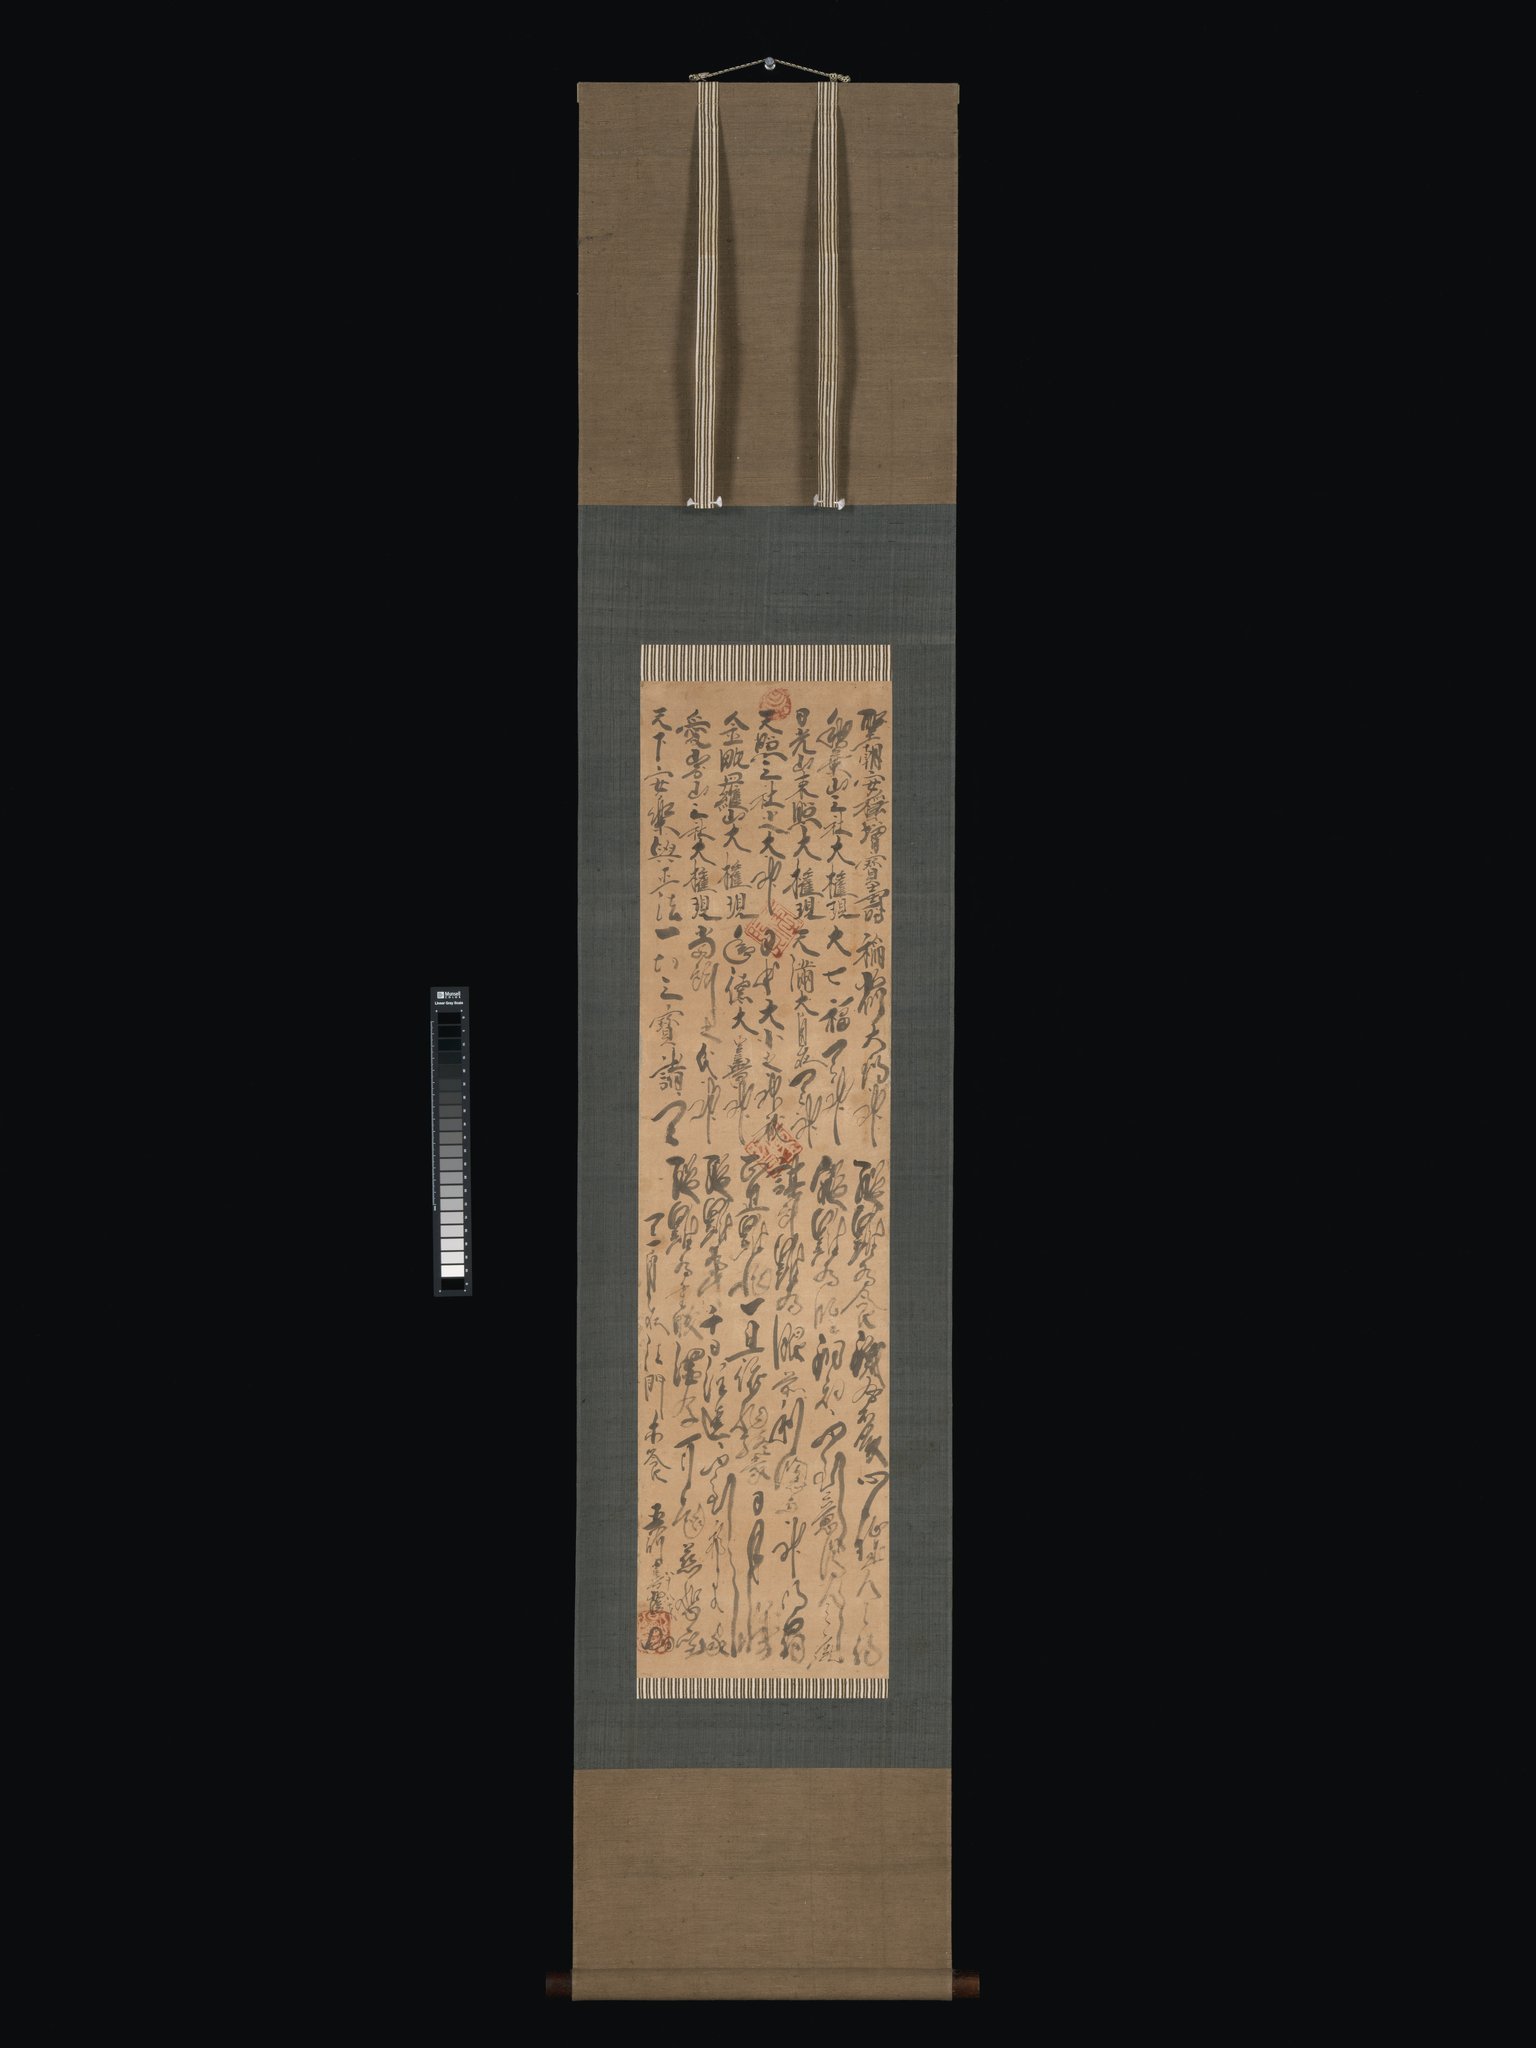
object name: hanging scroll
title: Sacred Names of Shinto Deities and the "Oracles of the Three Shrines"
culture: japanese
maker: mokujiki shōnin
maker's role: artist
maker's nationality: japanese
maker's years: 1718-1810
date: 1805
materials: ink, paper